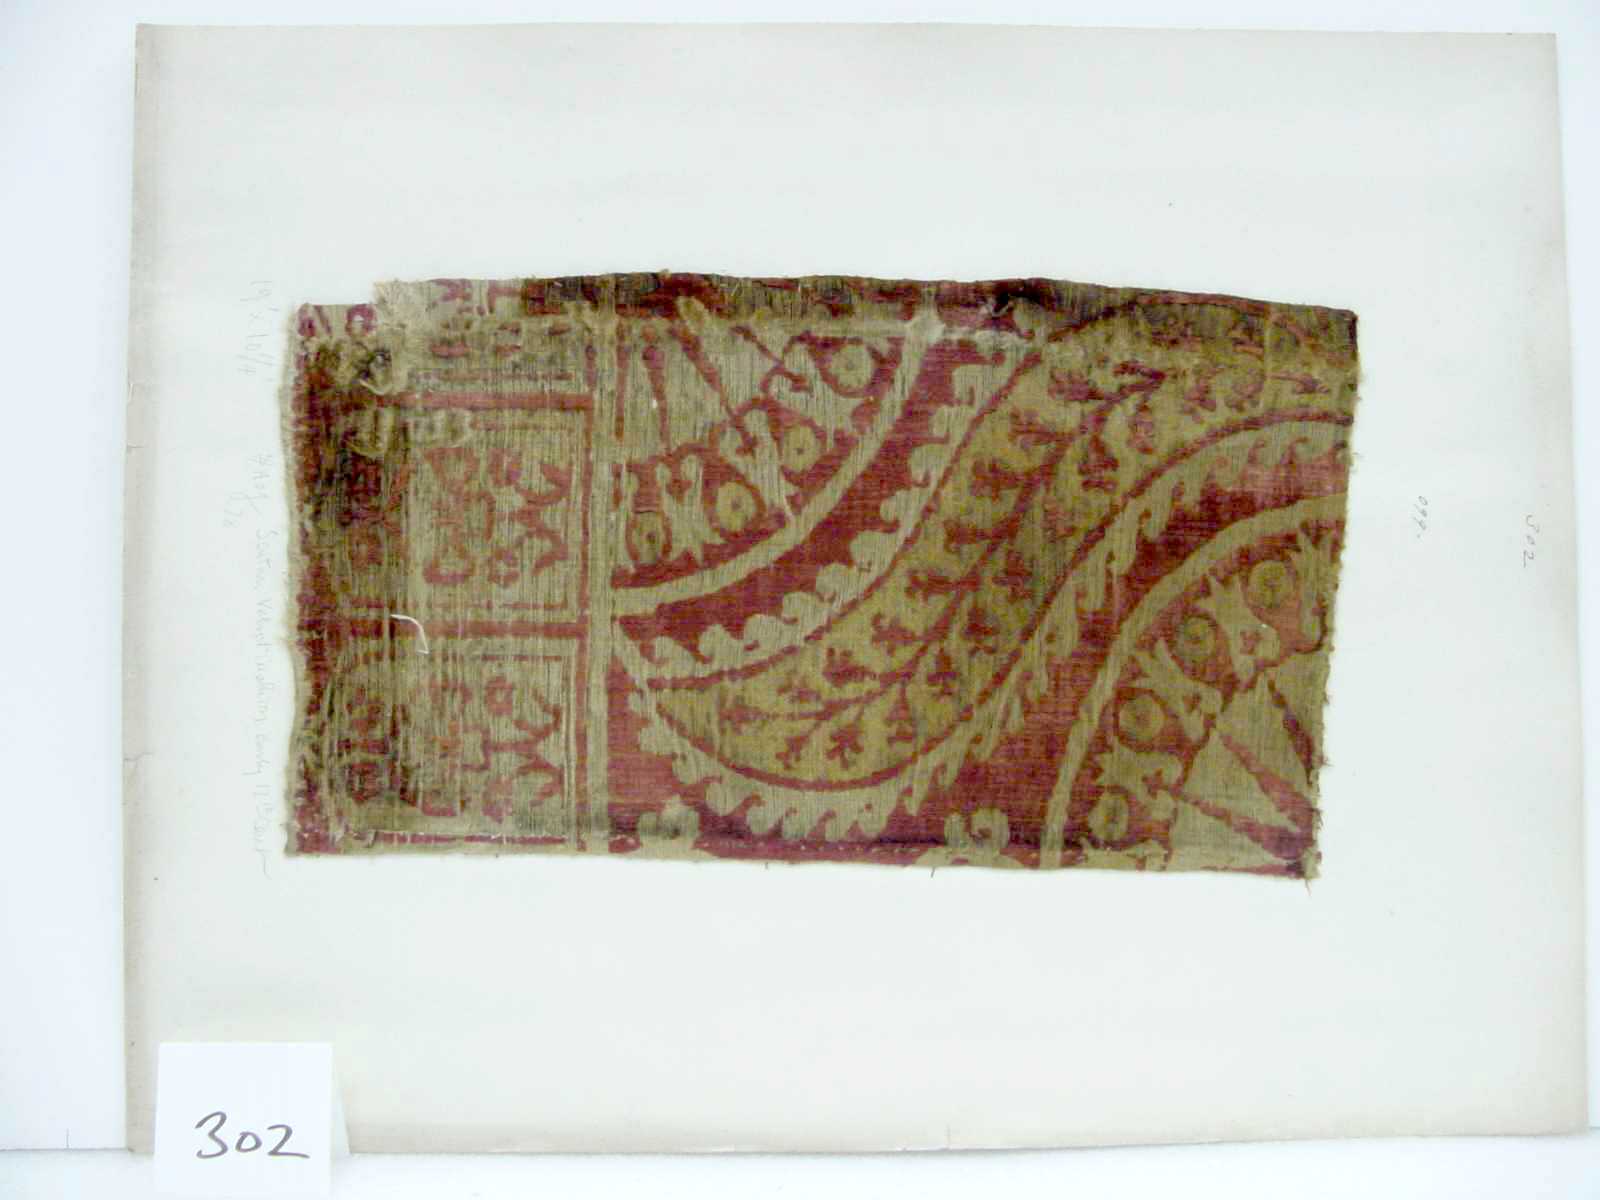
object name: textile fragment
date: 1601-1633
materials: silk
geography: turkey